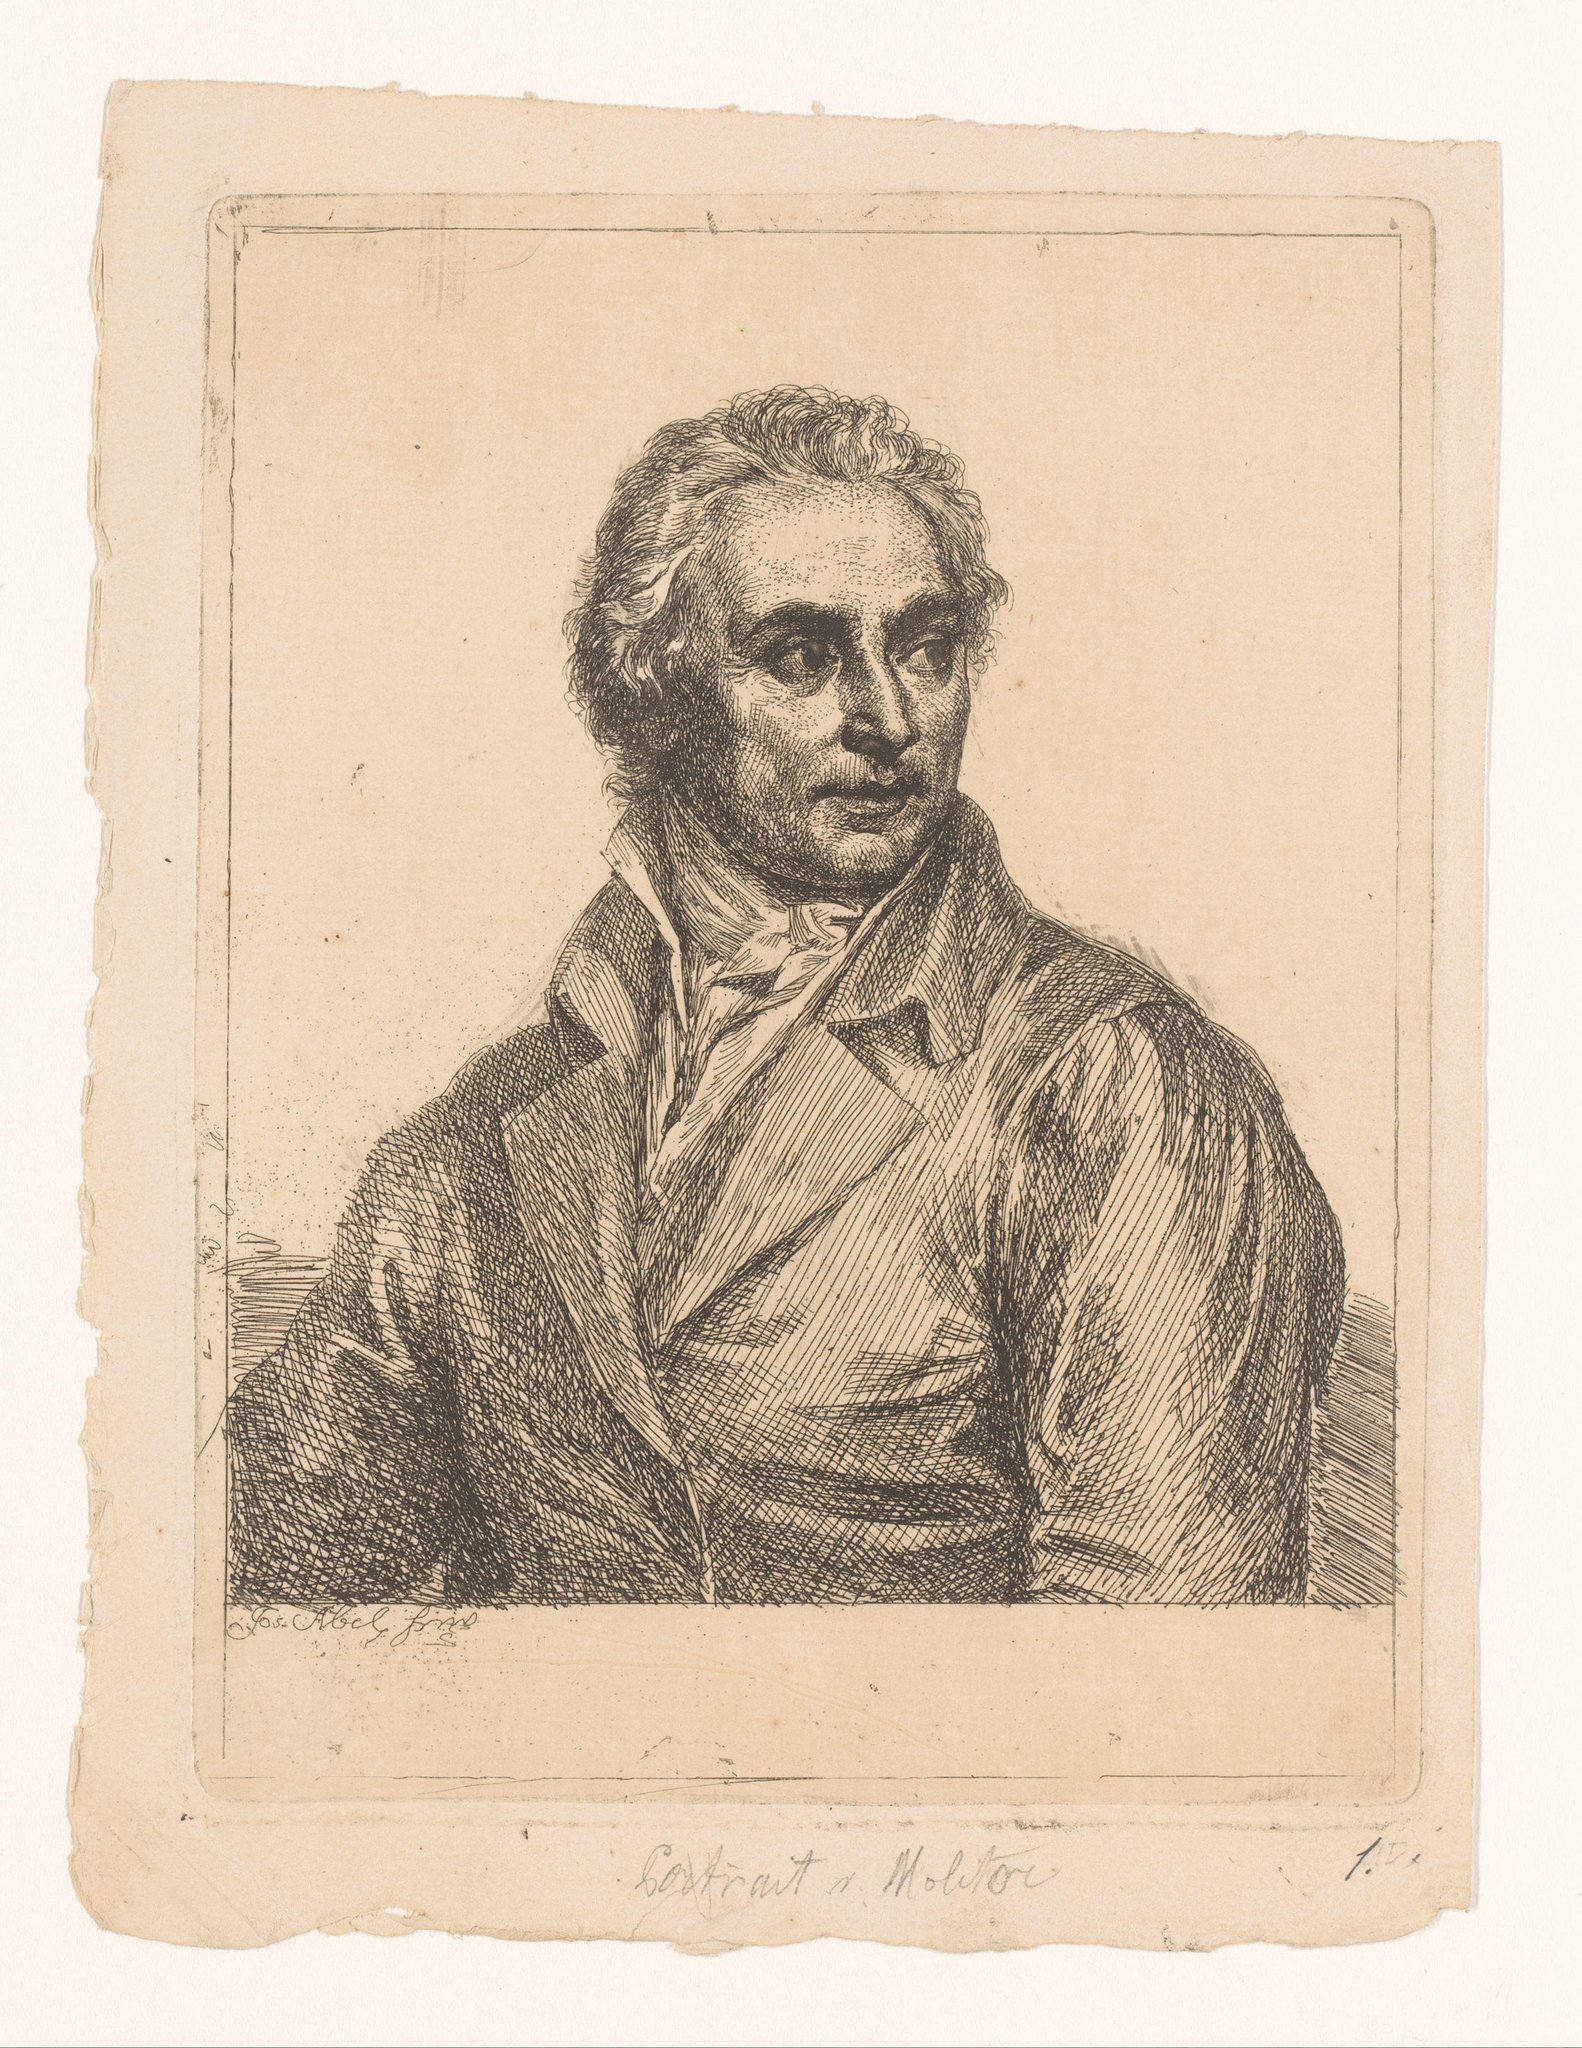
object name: print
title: Portret van Martin von Molitor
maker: joseph abel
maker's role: print maker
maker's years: 1764-1818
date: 1774-1818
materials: paper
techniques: etching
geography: vienna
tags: vienna, painter, martin von molitor, portrait, self-portrait of artist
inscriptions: collector's mark: Lugt 2228